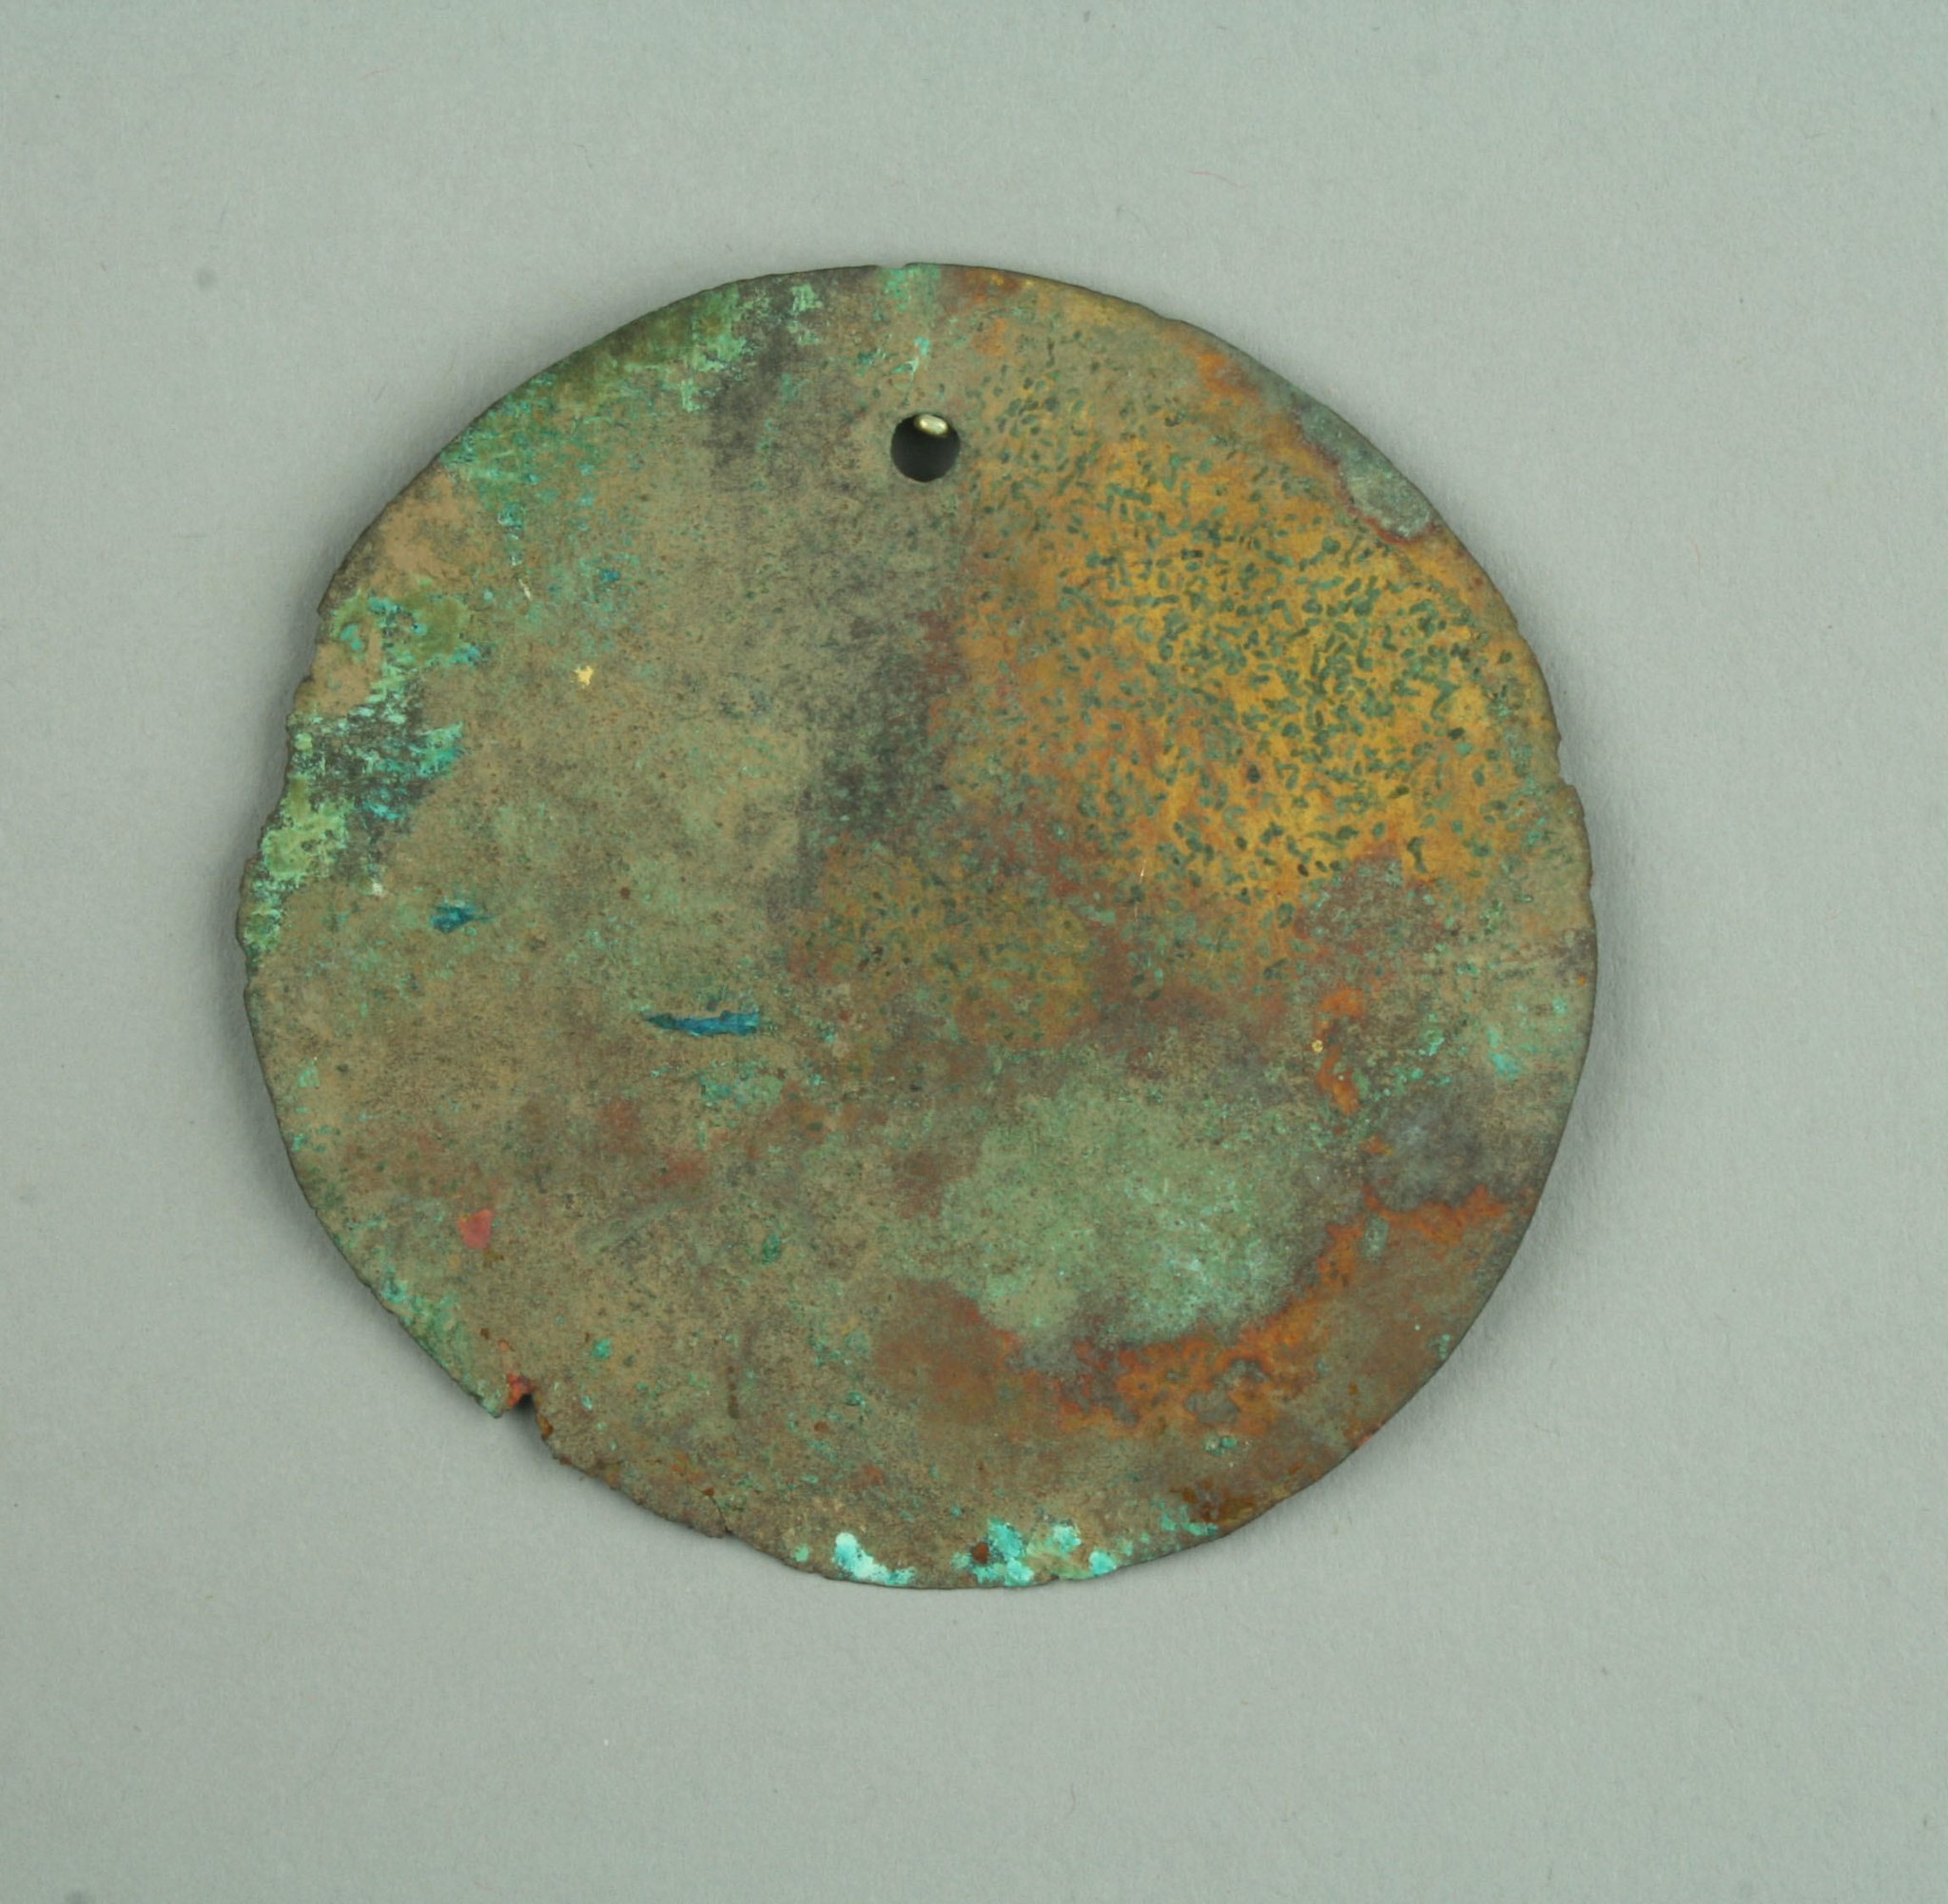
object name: plaque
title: Round Plaque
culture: vicús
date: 300 BCE-200 CE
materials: copper, gilt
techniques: hammering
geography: peru